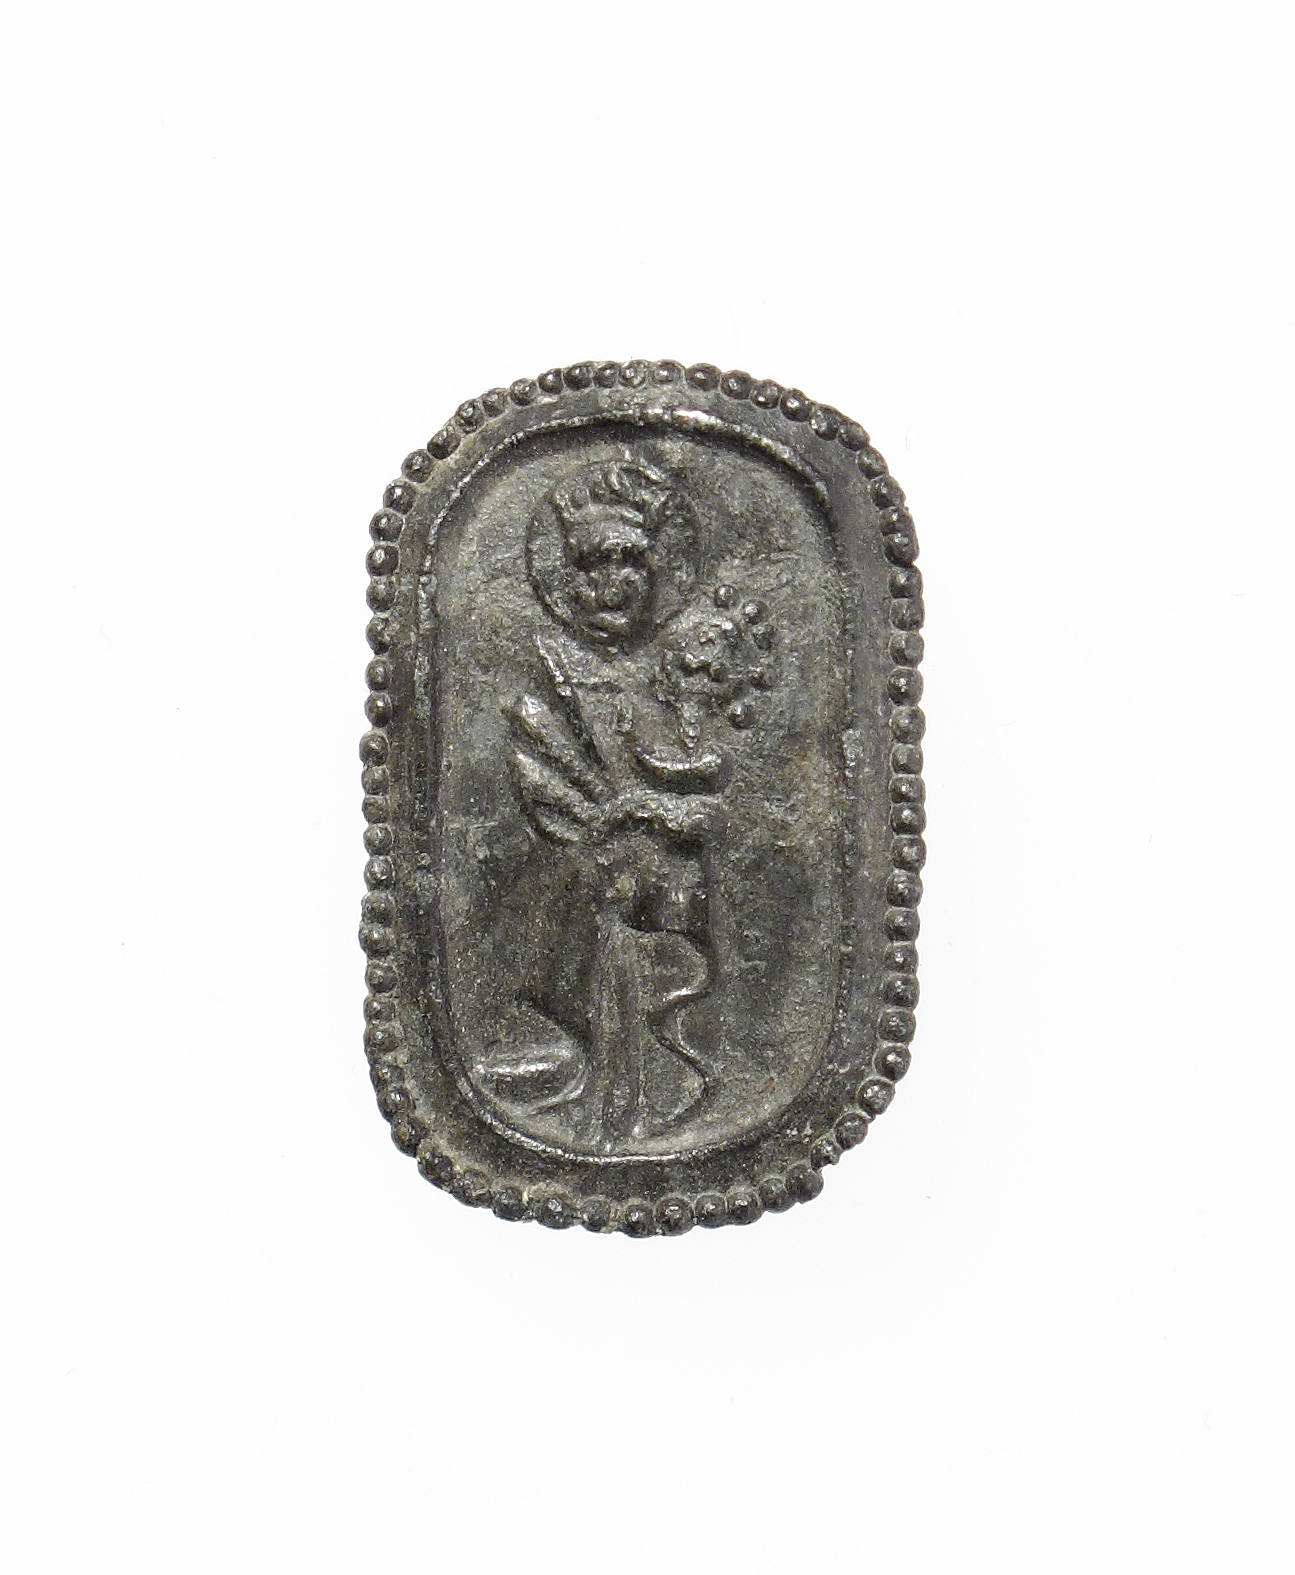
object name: pilgrim's badge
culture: french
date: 1301-1600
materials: lead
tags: madonna and child